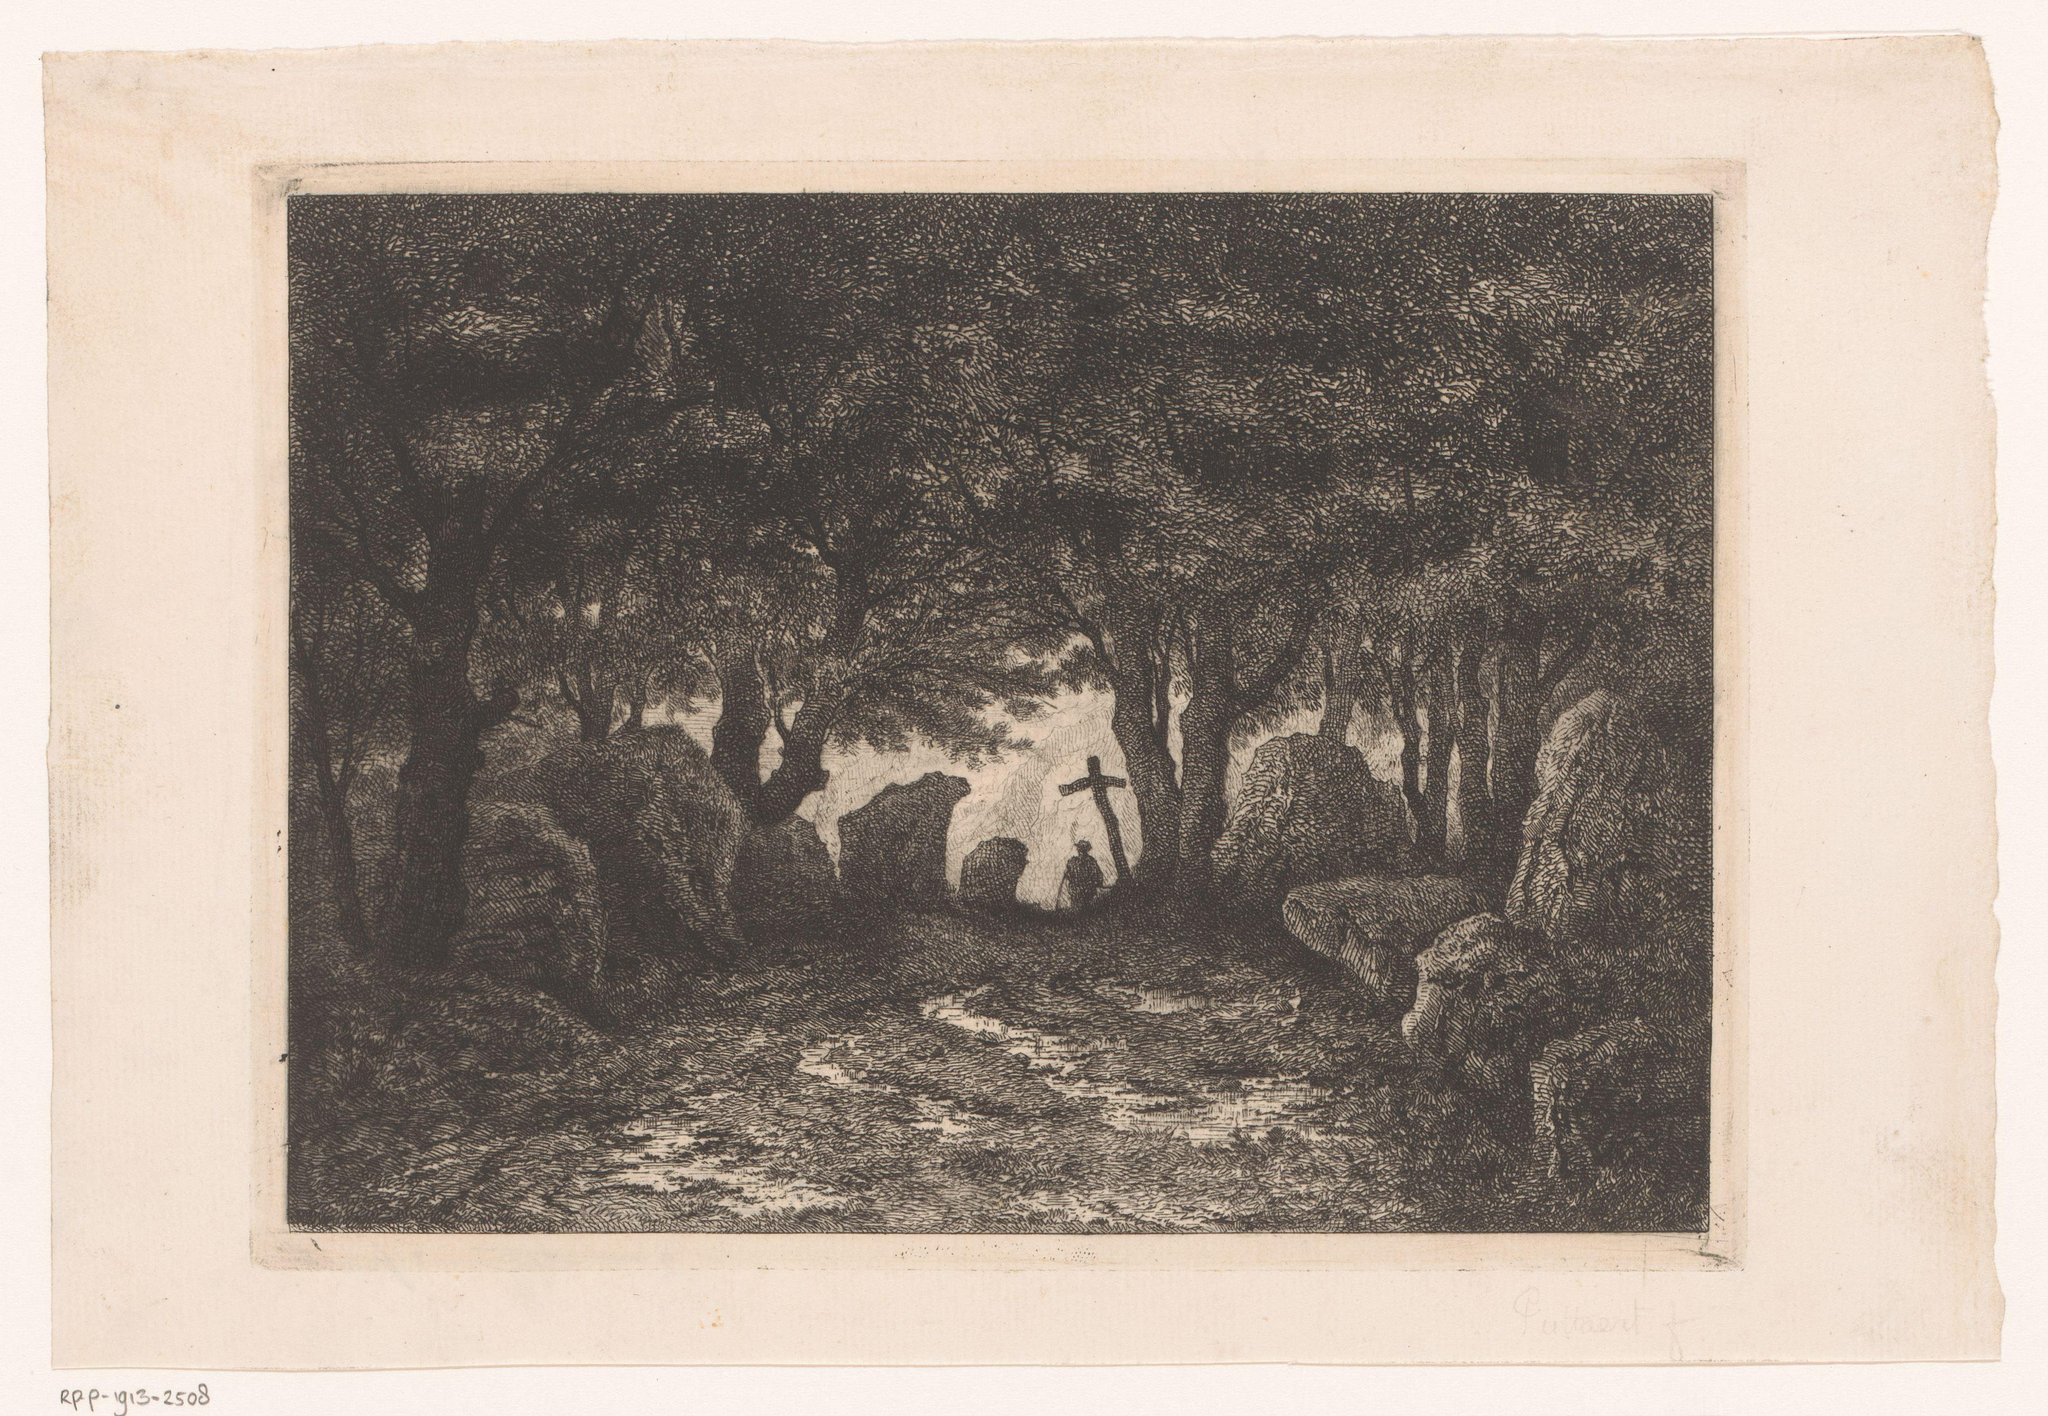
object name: print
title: Man bij een houten kruis aan de rand van een bos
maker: emile puttaert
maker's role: print maker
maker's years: 1829-1901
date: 1839-1901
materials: paper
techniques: drypoint, etching, intaglio, roulette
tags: the cross ~ symbols of christ, other kinds of grave-markers, e.g. cross, forest, wood (+ landscape with figures, staffage)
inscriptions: collector's mark: Lugt 2228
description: Prent toont veel overeenkomsten met RP-P-1913-2507, maar waarschijnlijk gaat het om een andere plaat.